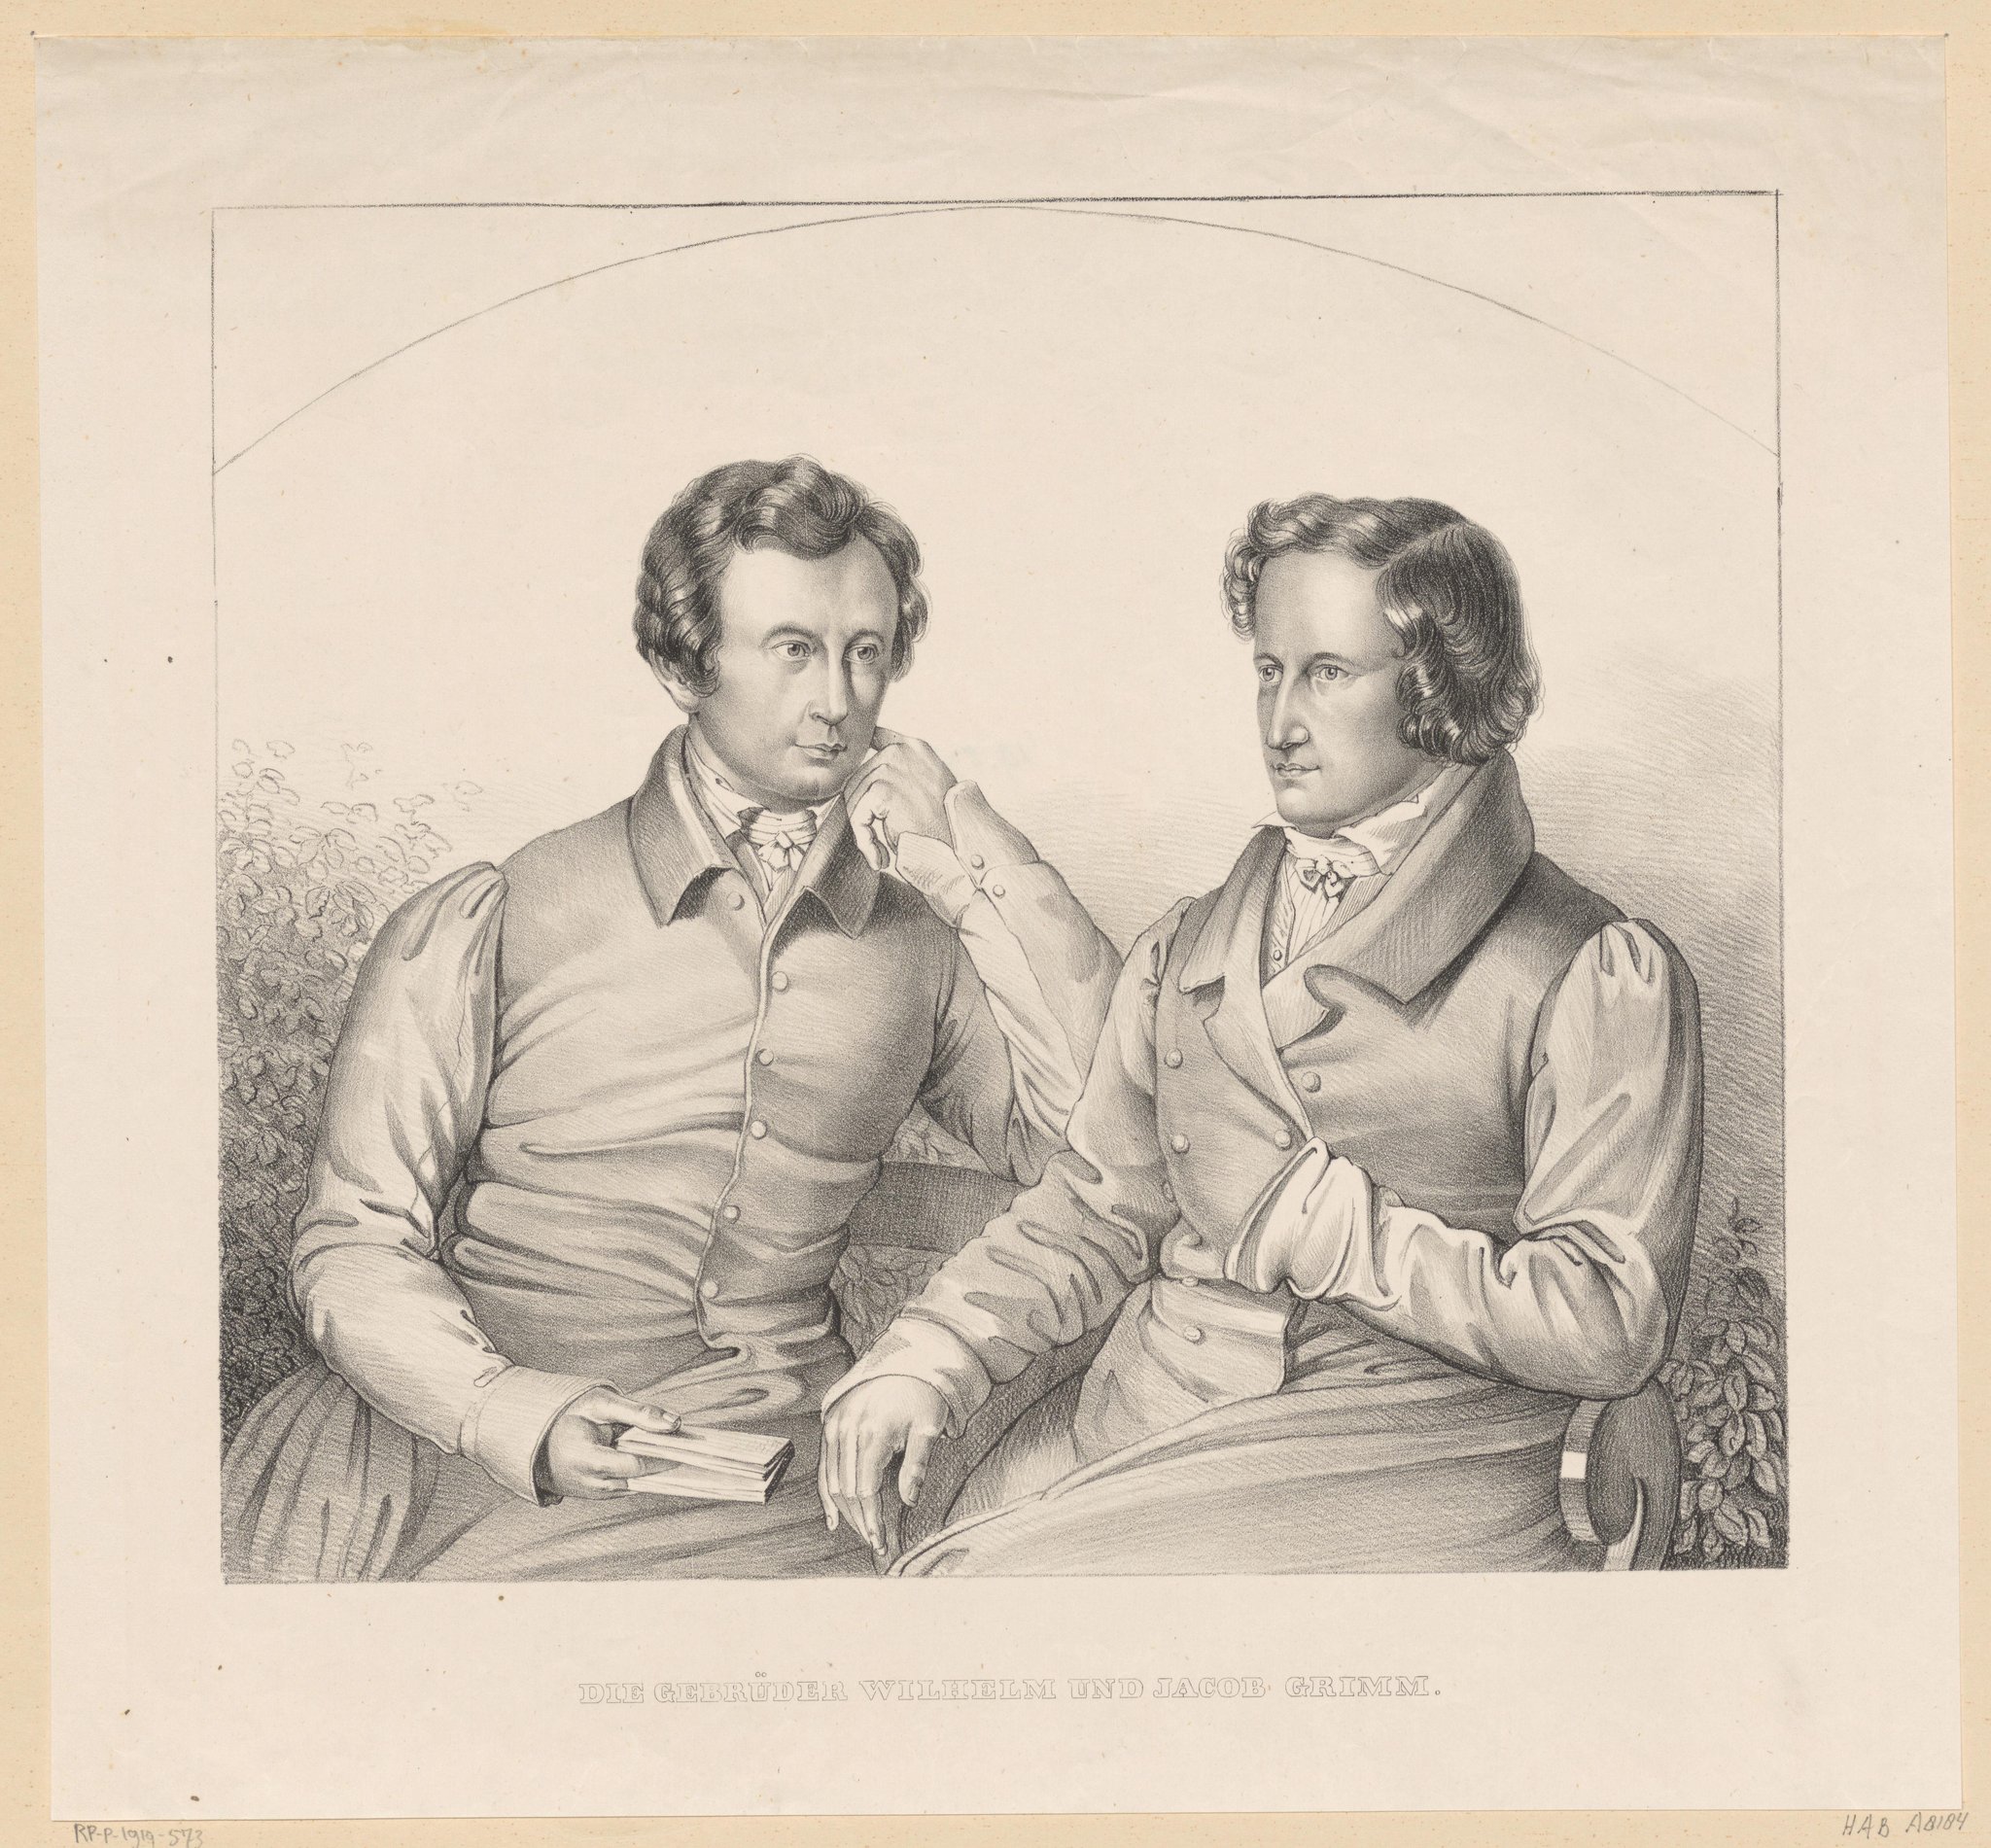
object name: print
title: Portret van Jacob Ludwig Karl Grimm en Wilhelm Karl Grimm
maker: ludwig emil grimm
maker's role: print maker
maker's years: 1790-1863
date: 1830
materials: paper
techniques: lithograph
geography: berlin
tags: berlin, jacob ludwig karl grimm, historical persons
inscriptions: collector's mark: Lugt 2228